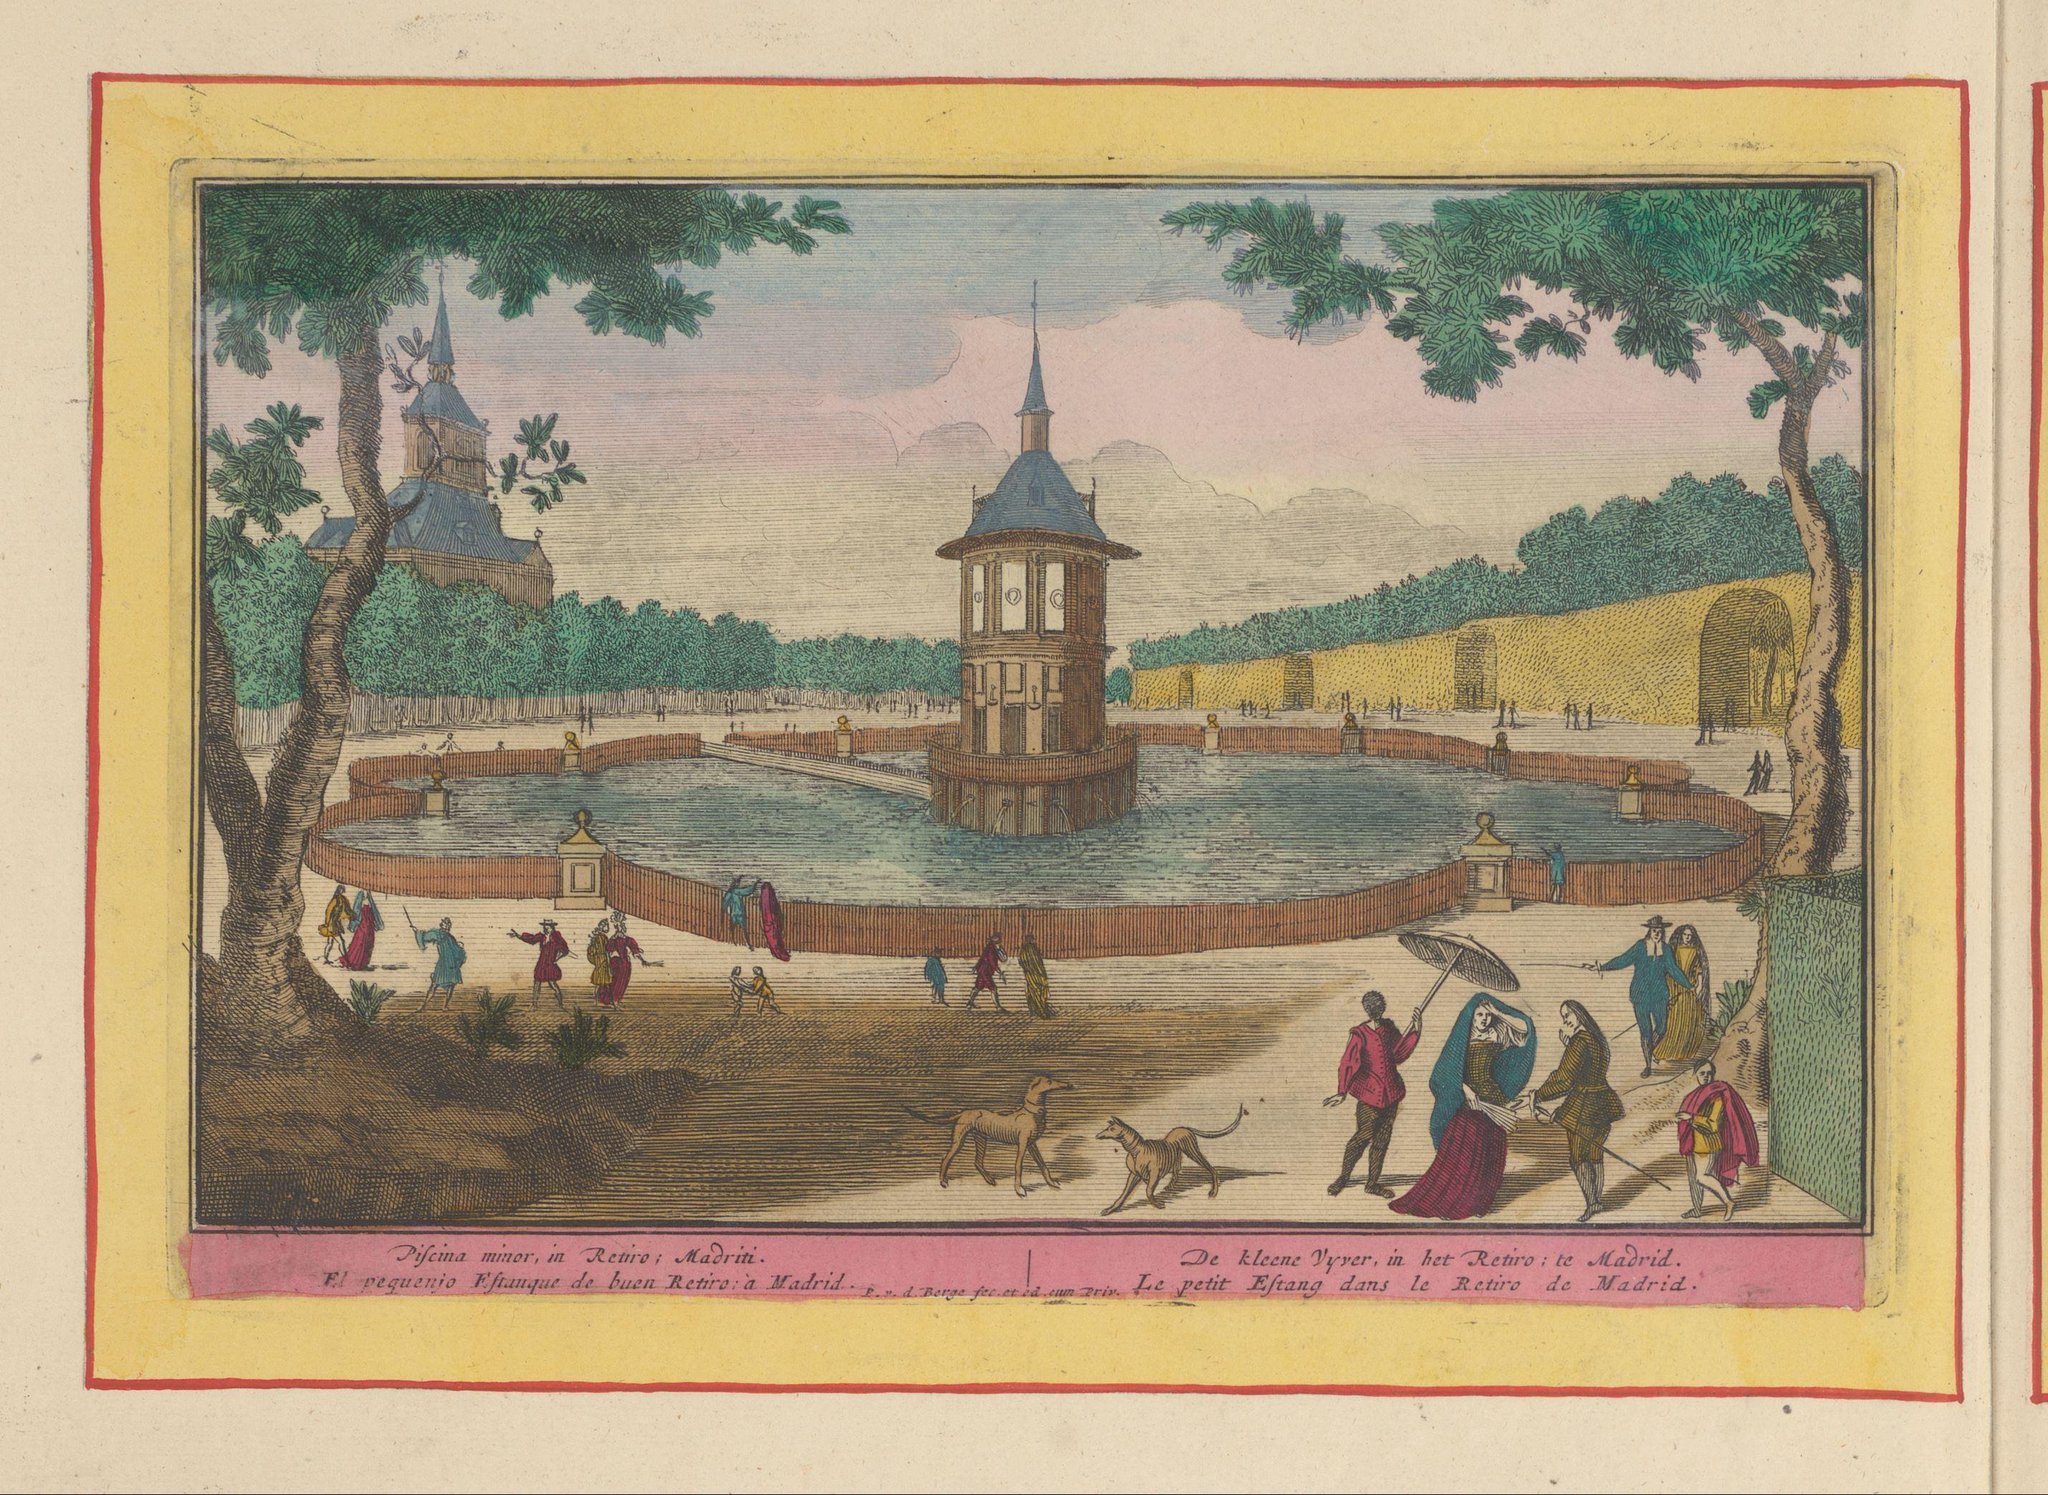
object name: book illustration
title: Theatrum Hispaniae (...)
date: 1694-1737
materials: paper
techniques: etching, hand coloring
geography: amsterdam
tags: garden pond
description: Prent uit: Theatrum Hispaniæ, exhibens regni urbes, villas ac viridaria magis illustria. Het aanmerkelykste en voortreffelykste in Spanjen (...). Amsterdam: Pieter van den Berge, ca. 1694-1737.